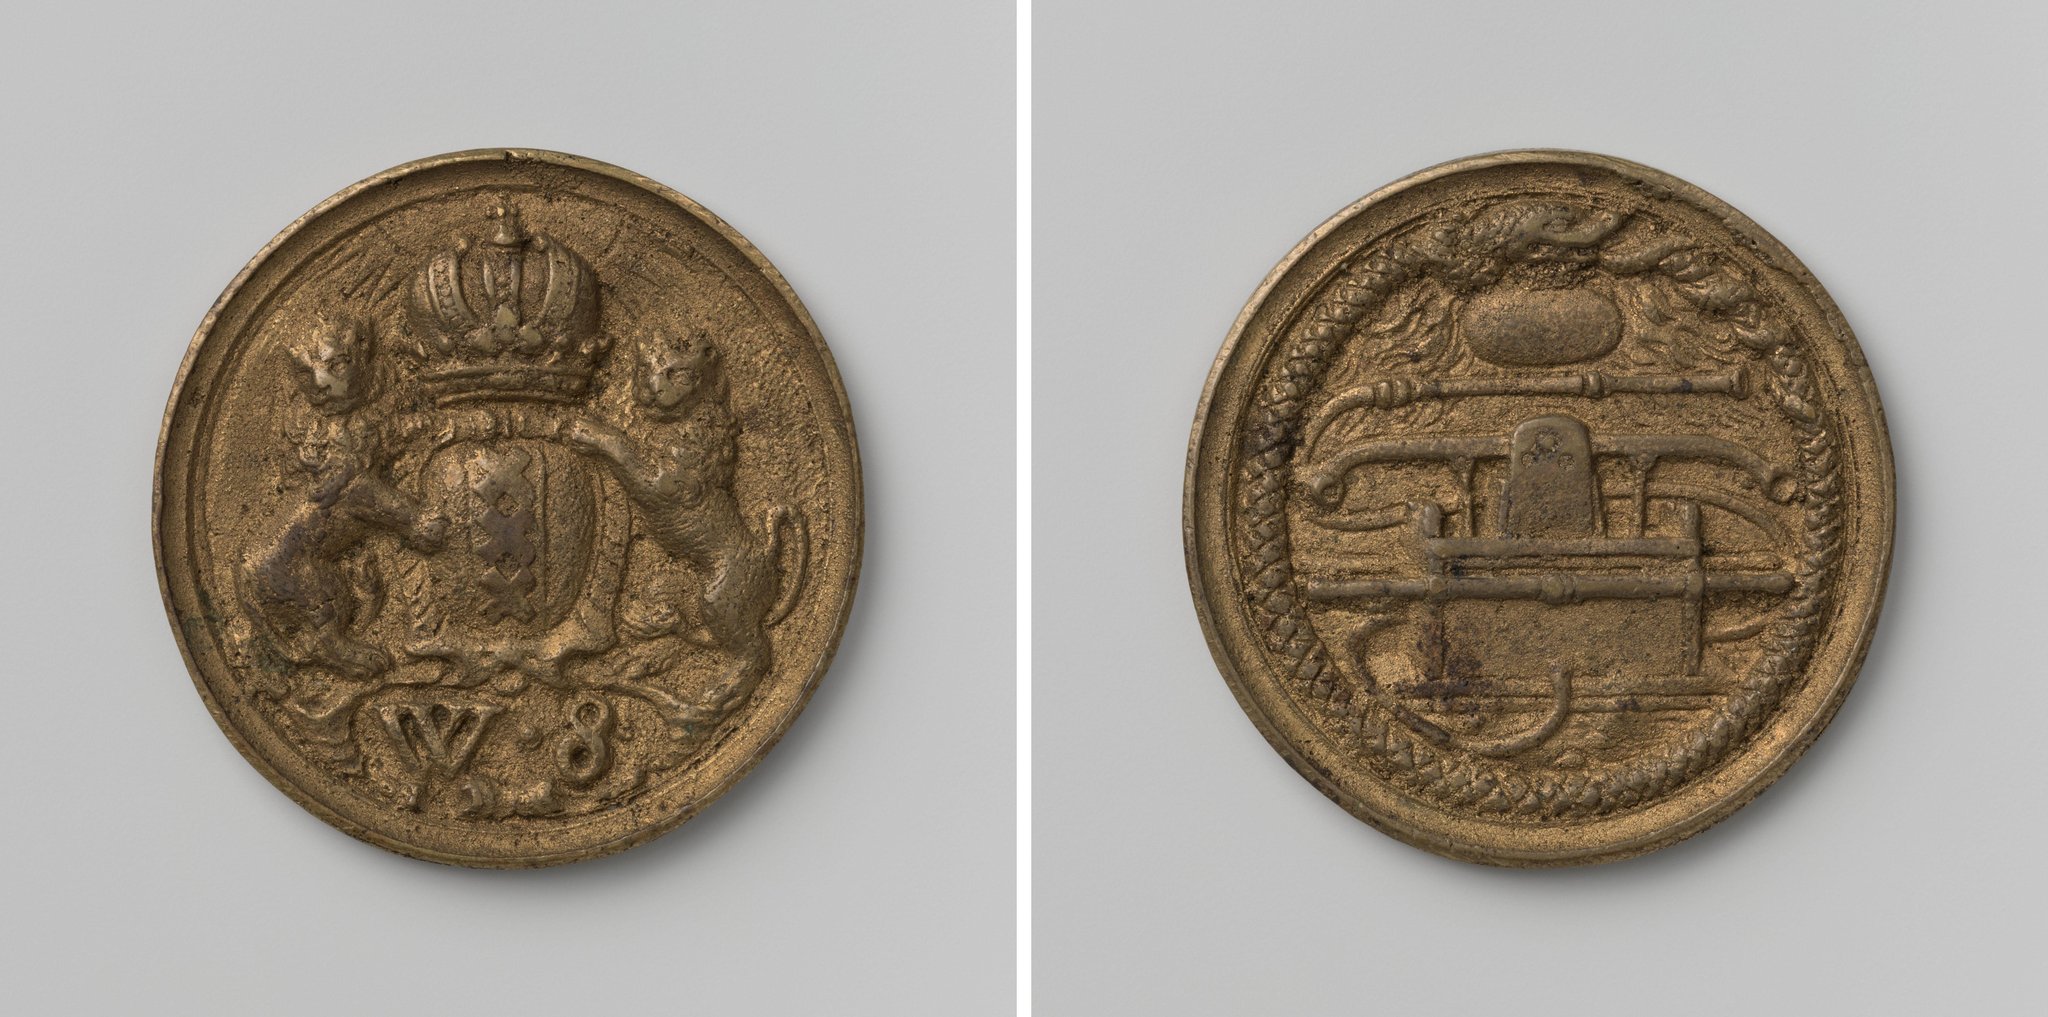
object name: fire engine medal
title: Amsterdam, brandspuitpenning van wijk 8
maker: Anonymous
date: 1680-1800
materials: brass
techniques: casting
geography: amsterdam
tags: amsterdam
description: Messing penning. Voorzijde: gekroond wapenschild, geflankeerd door twee leeuwen boven cartouche met opschrift W 8. Keerzijde: brandspuit onder leeg cartouche binnen slangerond